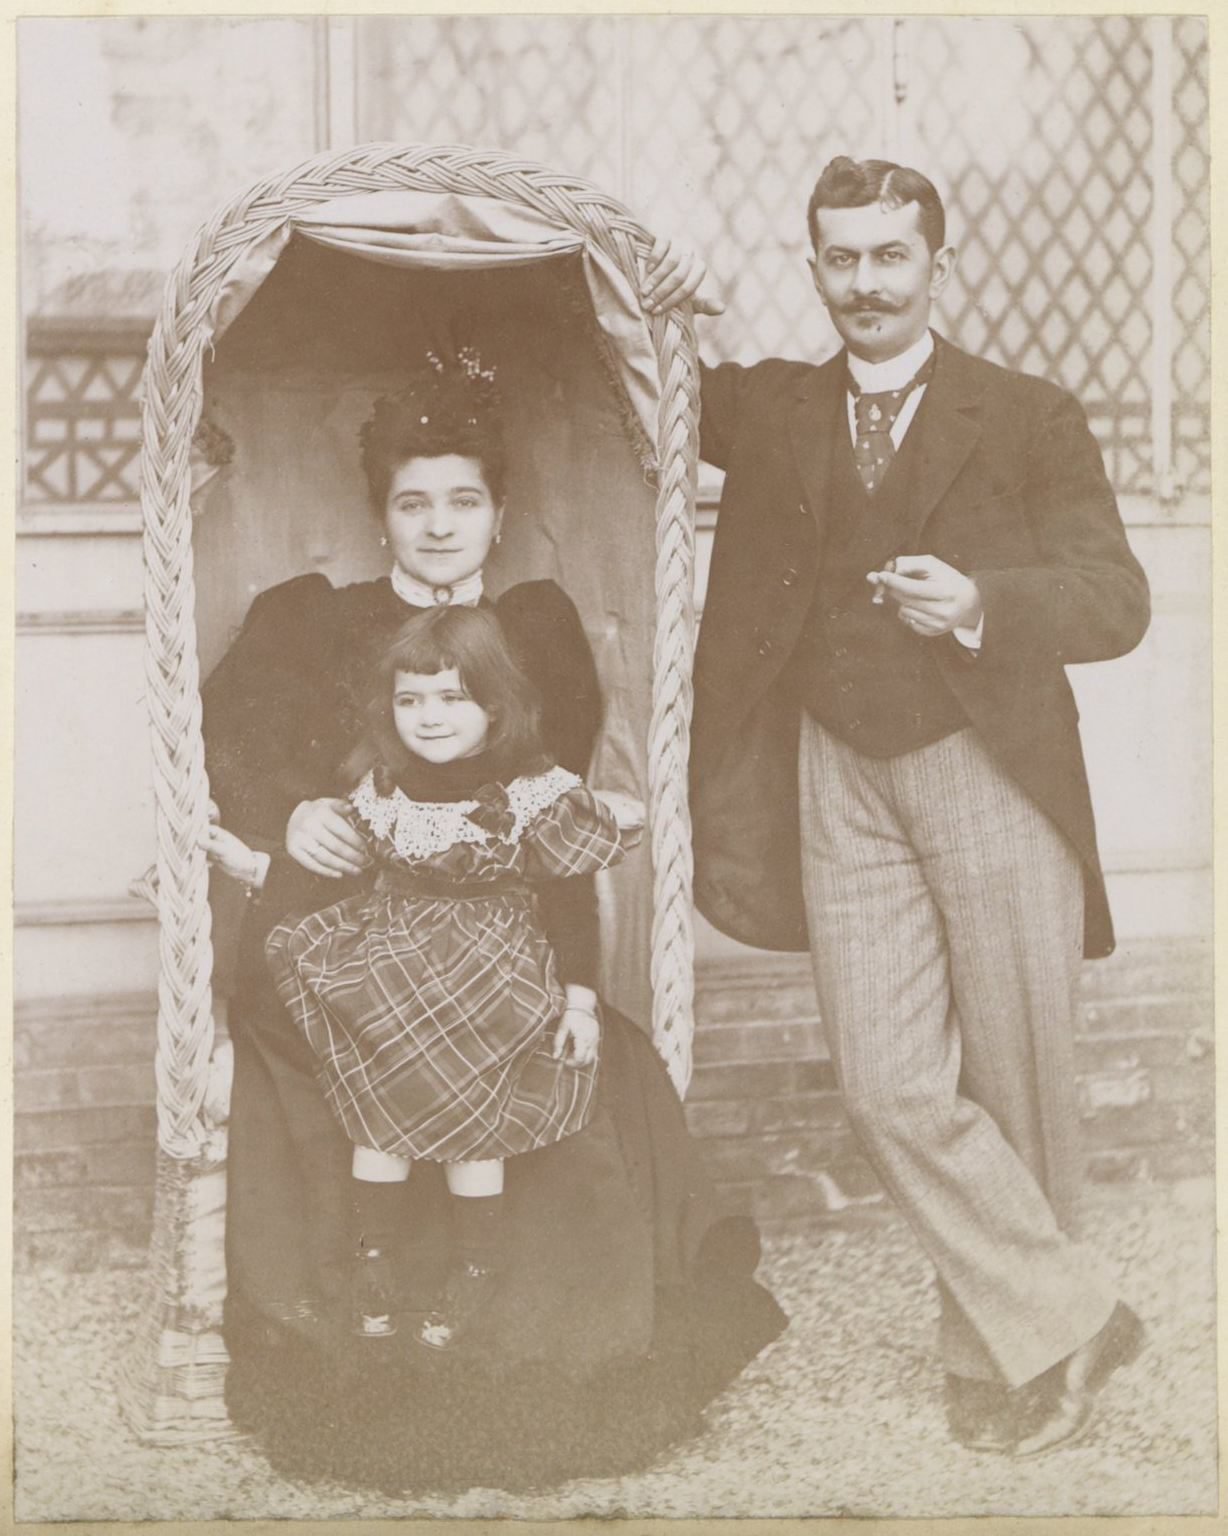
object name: photograph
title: Portret van een Frans stel met een kind in een geruite jurk, bij een strandstoel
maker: Anonymous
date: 1900-1910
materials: paper, photographic support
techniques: daylight paper print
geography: france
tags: family group, especially parents with their child(ren), dress, gown, chair, france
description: Onderdeel van Fotoalbum van een Franse amateurfotograaf met opnames van een familie, distilleerderij Delizy & Doistau Fils, het leger en bezienswaardigheden in Frankrijk.